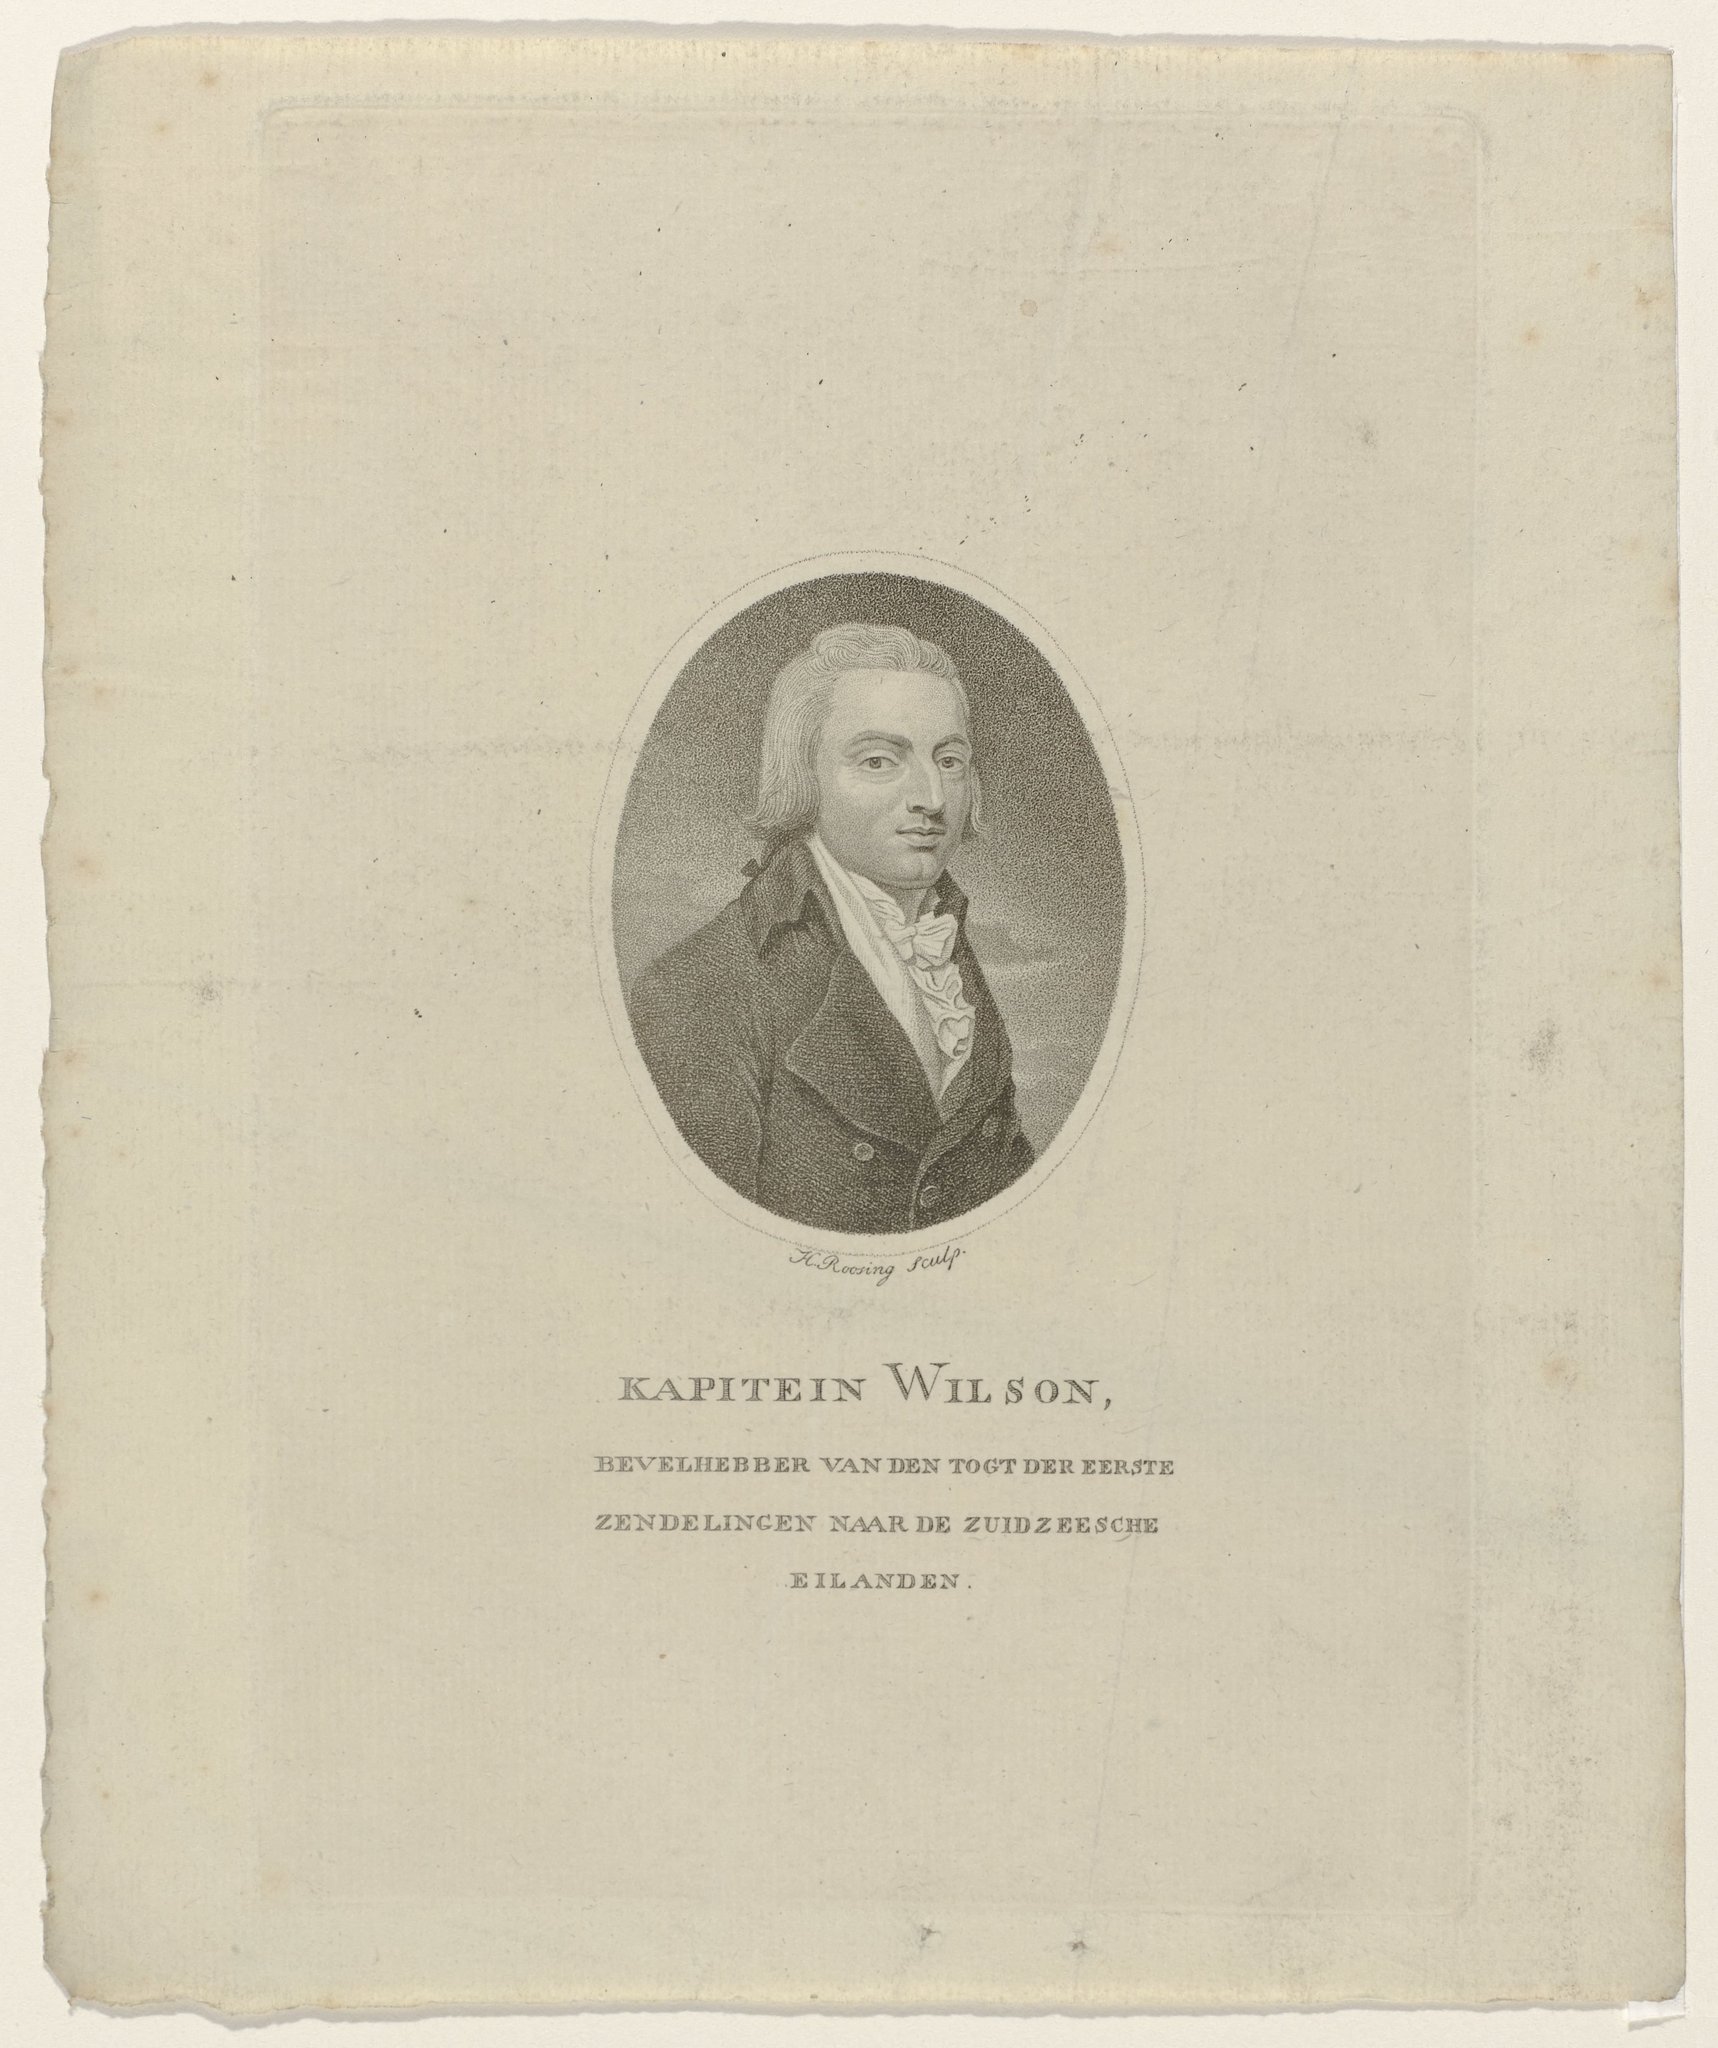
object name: print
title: Portret van Kapitein Wilson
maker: hendrik roosing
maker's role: print maker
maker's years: 1763-1826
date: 1786-1826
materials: paper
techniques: stippled etching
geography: rotterdam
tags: historical persons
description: Portret van Kapitein Wilson in ovaal naar rechts. Onder ovaal de tekst: Kapitein Wilson, Bevelhebber van den togt der eerste zendelingen naar de zuidzeesche eilanden.